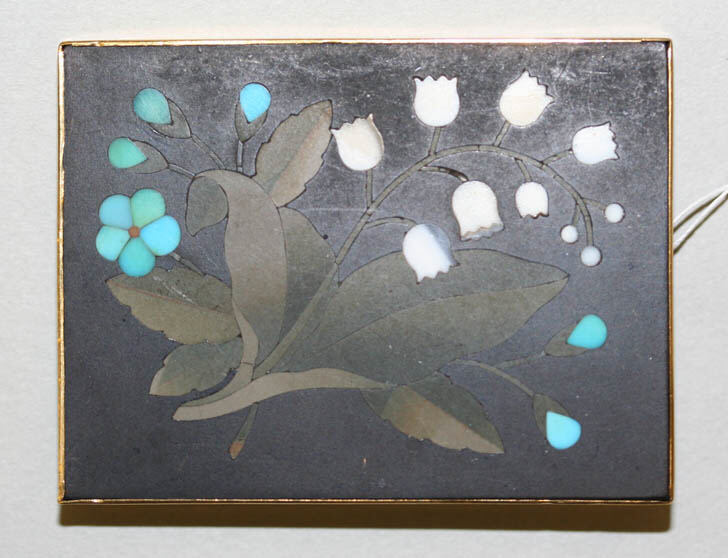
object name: brooch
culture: european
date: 1801-1900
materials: metal, stone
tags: flowers